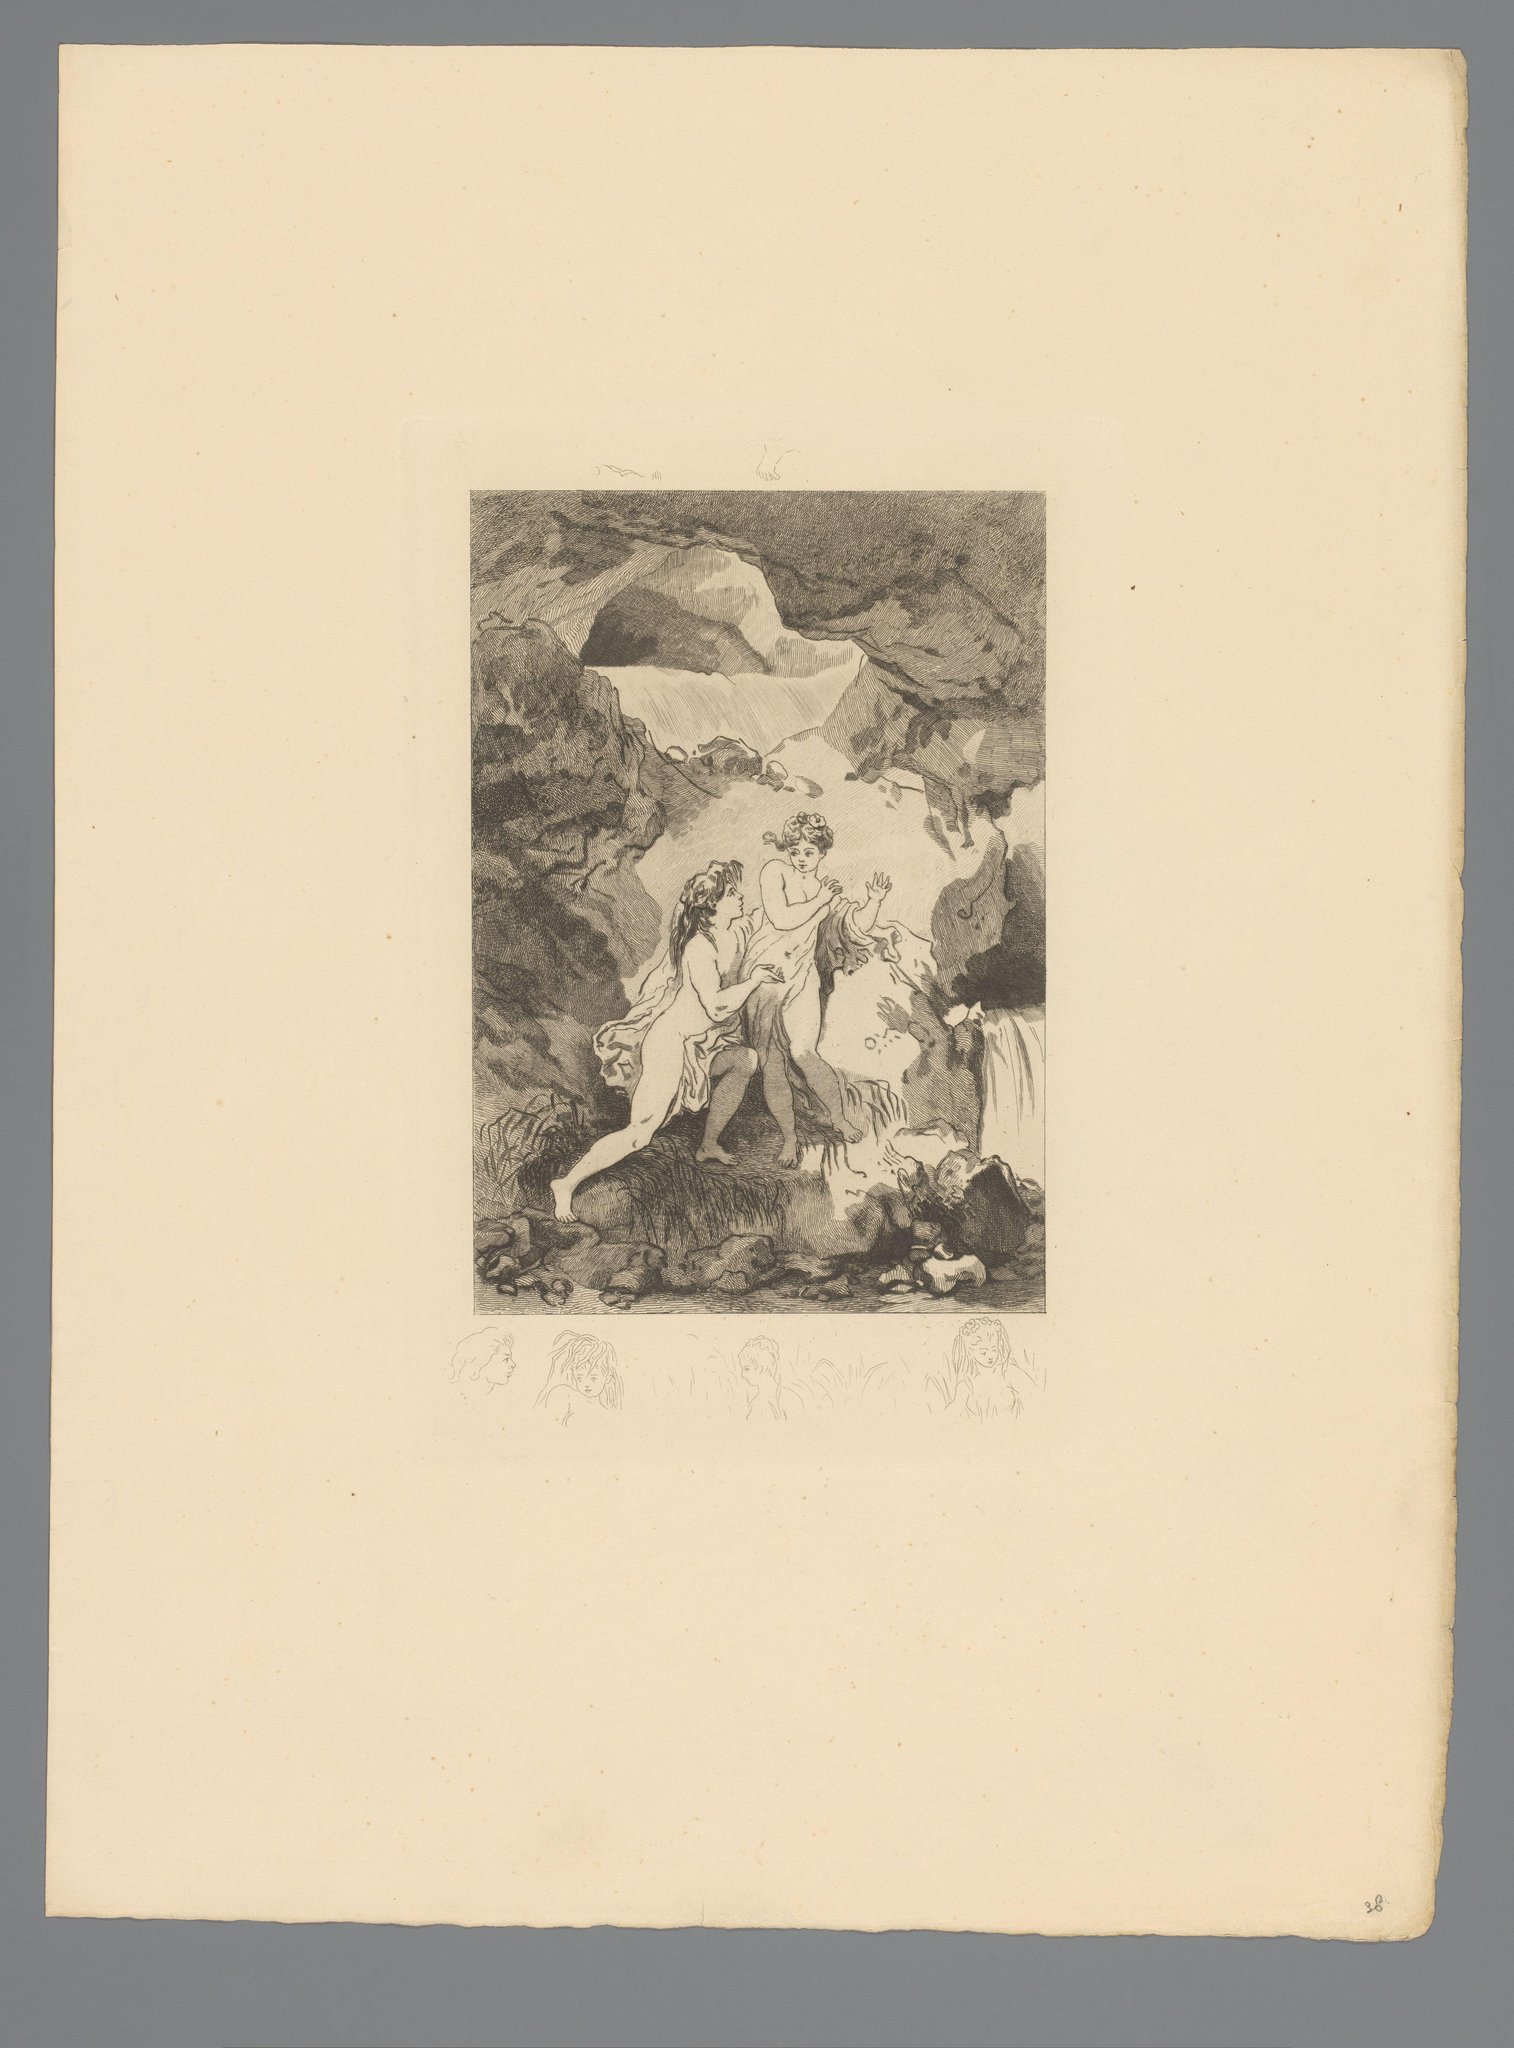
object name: reproduction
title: Reproductie van een prent naar een tekening van Cimon die een naakte vrouw achtervolgt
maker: Anonymous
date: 1880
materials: paper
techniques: photoaquatint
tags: river-gods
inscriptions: collector's mark:, collector's mark: Lugt 2228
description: Martial Potémont maakte etsen naar de tekeningen van Fragonard, die zich bevonden in een manuscript in de collectie van de verzamelaar Eugène Paillet. Rouquette bood hem aan de tekeningen zo exact mogelijk in prent te laten brengen door Martial Potémont: dit resulteerde in een serie van 57 etsen. Vervolgens werden deze gereproduceerd door middel van heliogravure. Deze omslag betreft een editie voor de letter, "Eau forte pure", de 1e staat van 3 waar men uit kon kiezen bij deze serie.